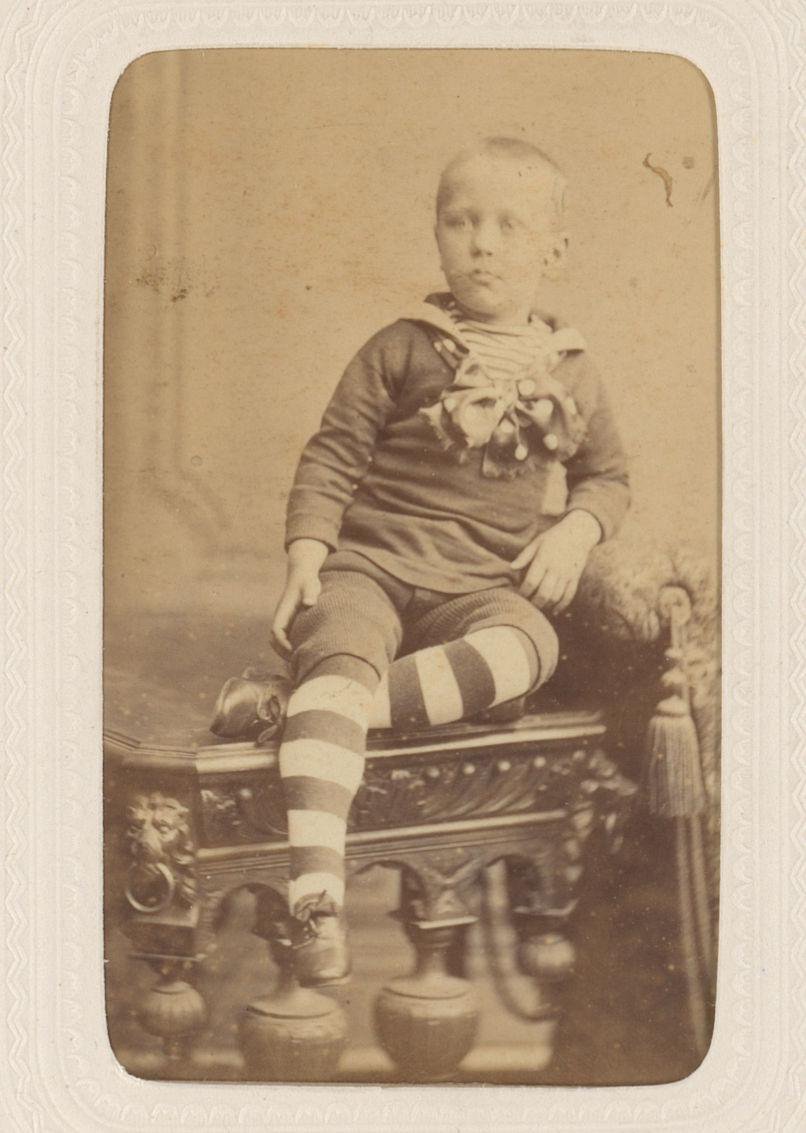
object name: carte de visite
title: Studioportret van een jongen op een tafel, gekleed in een matrozenpakje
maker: albert greiner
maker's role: fotograaf, fotostudio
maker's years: 1833-1890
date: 1863-1866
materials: cardboard, paper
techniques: albumen print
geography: amsterdam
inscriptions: name: ‘Albert Greiner Amsterdam’